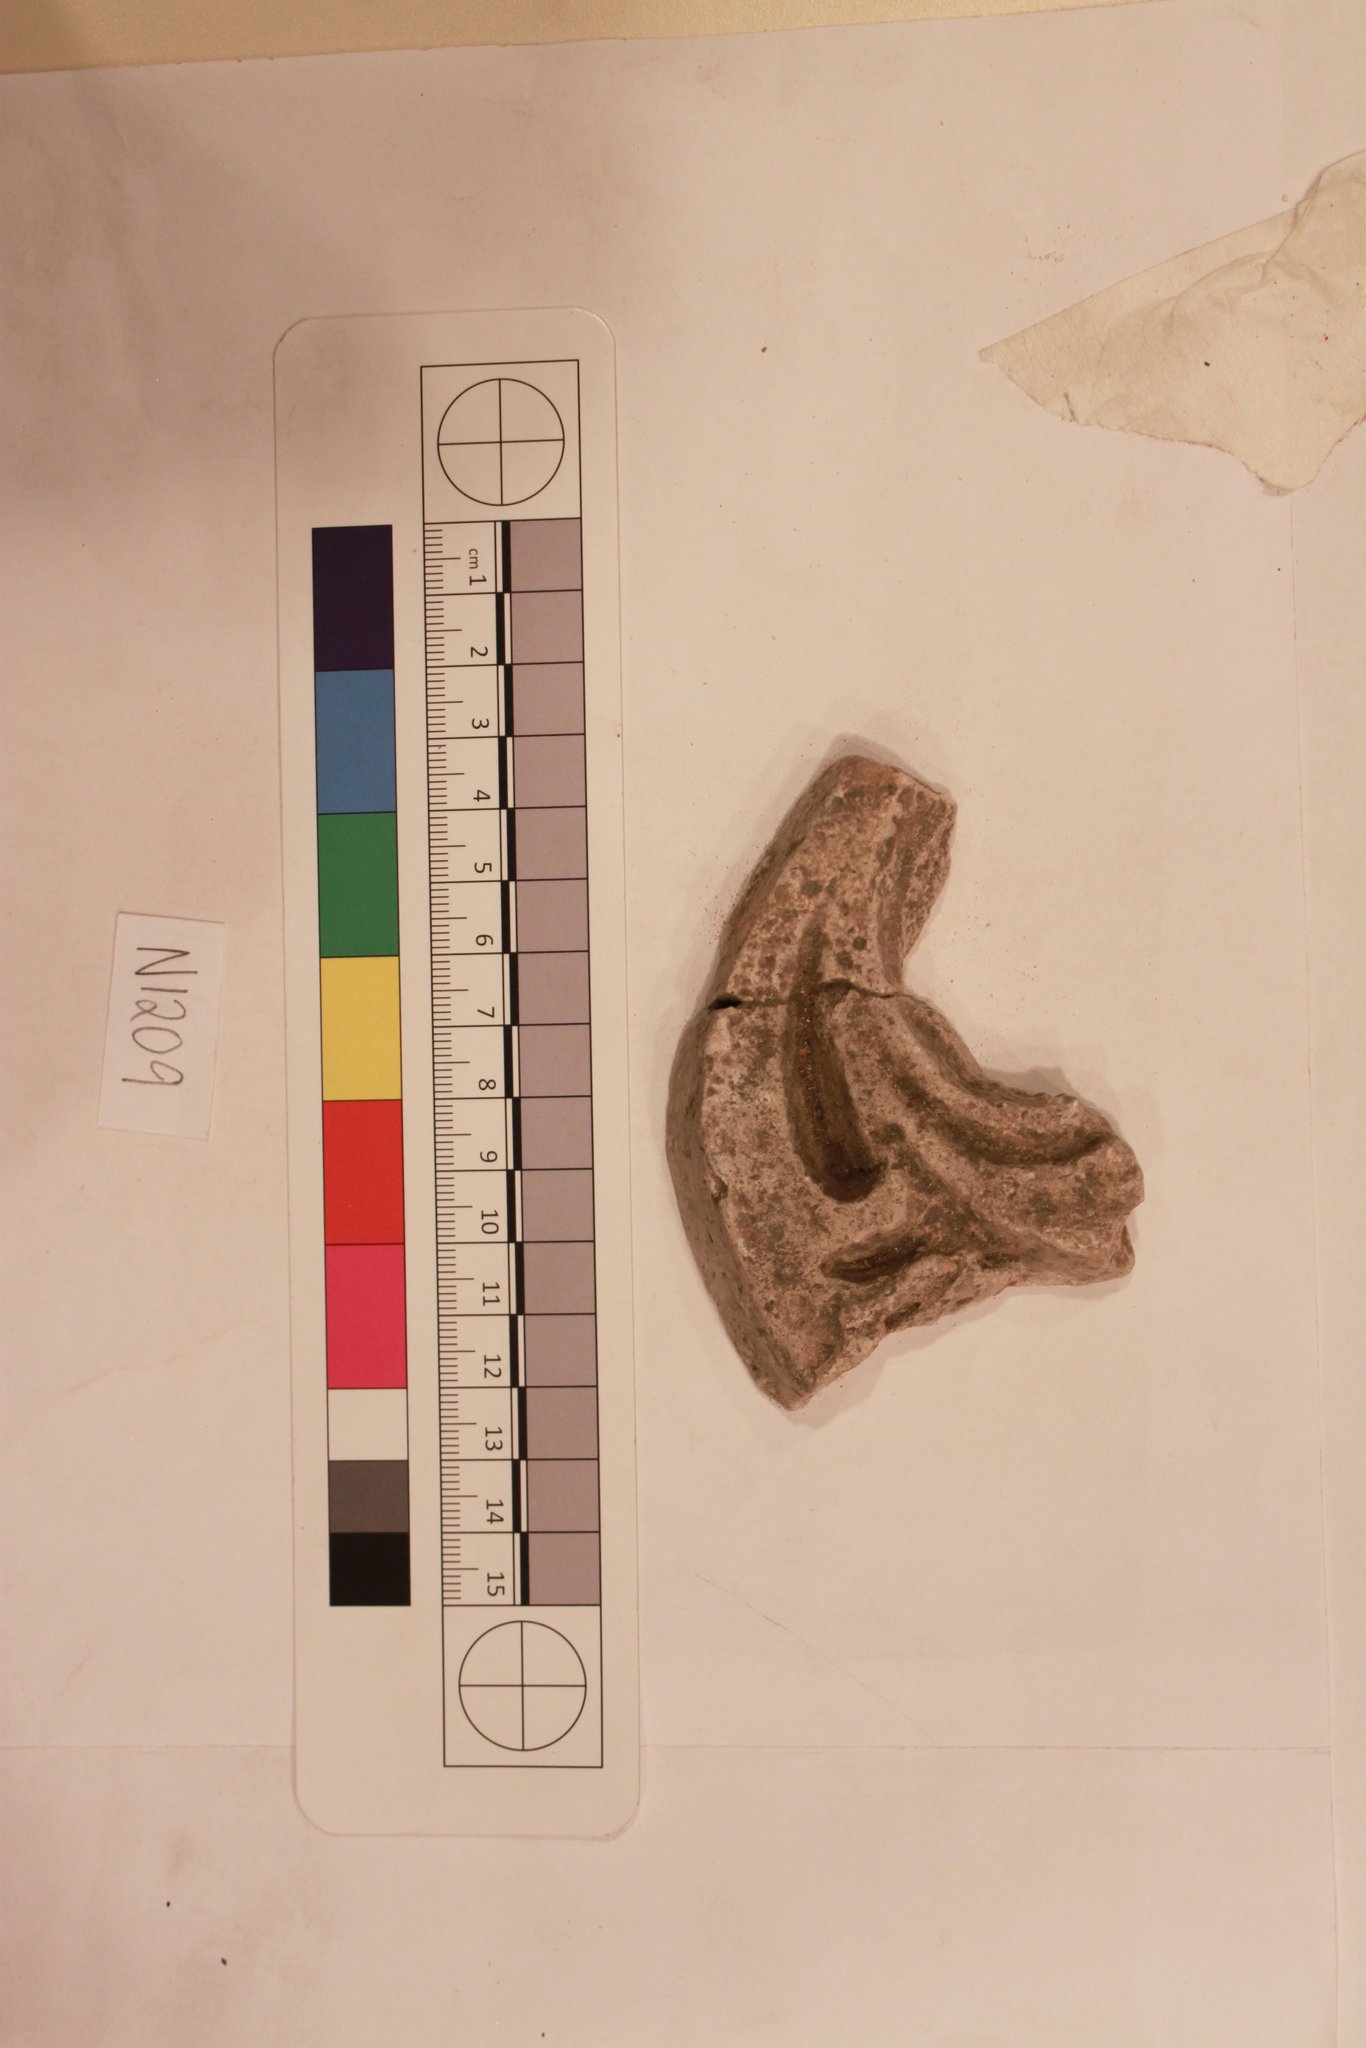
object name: fragment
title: Stucco Fragment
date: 701-1200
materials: plaster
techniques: carving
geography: iran